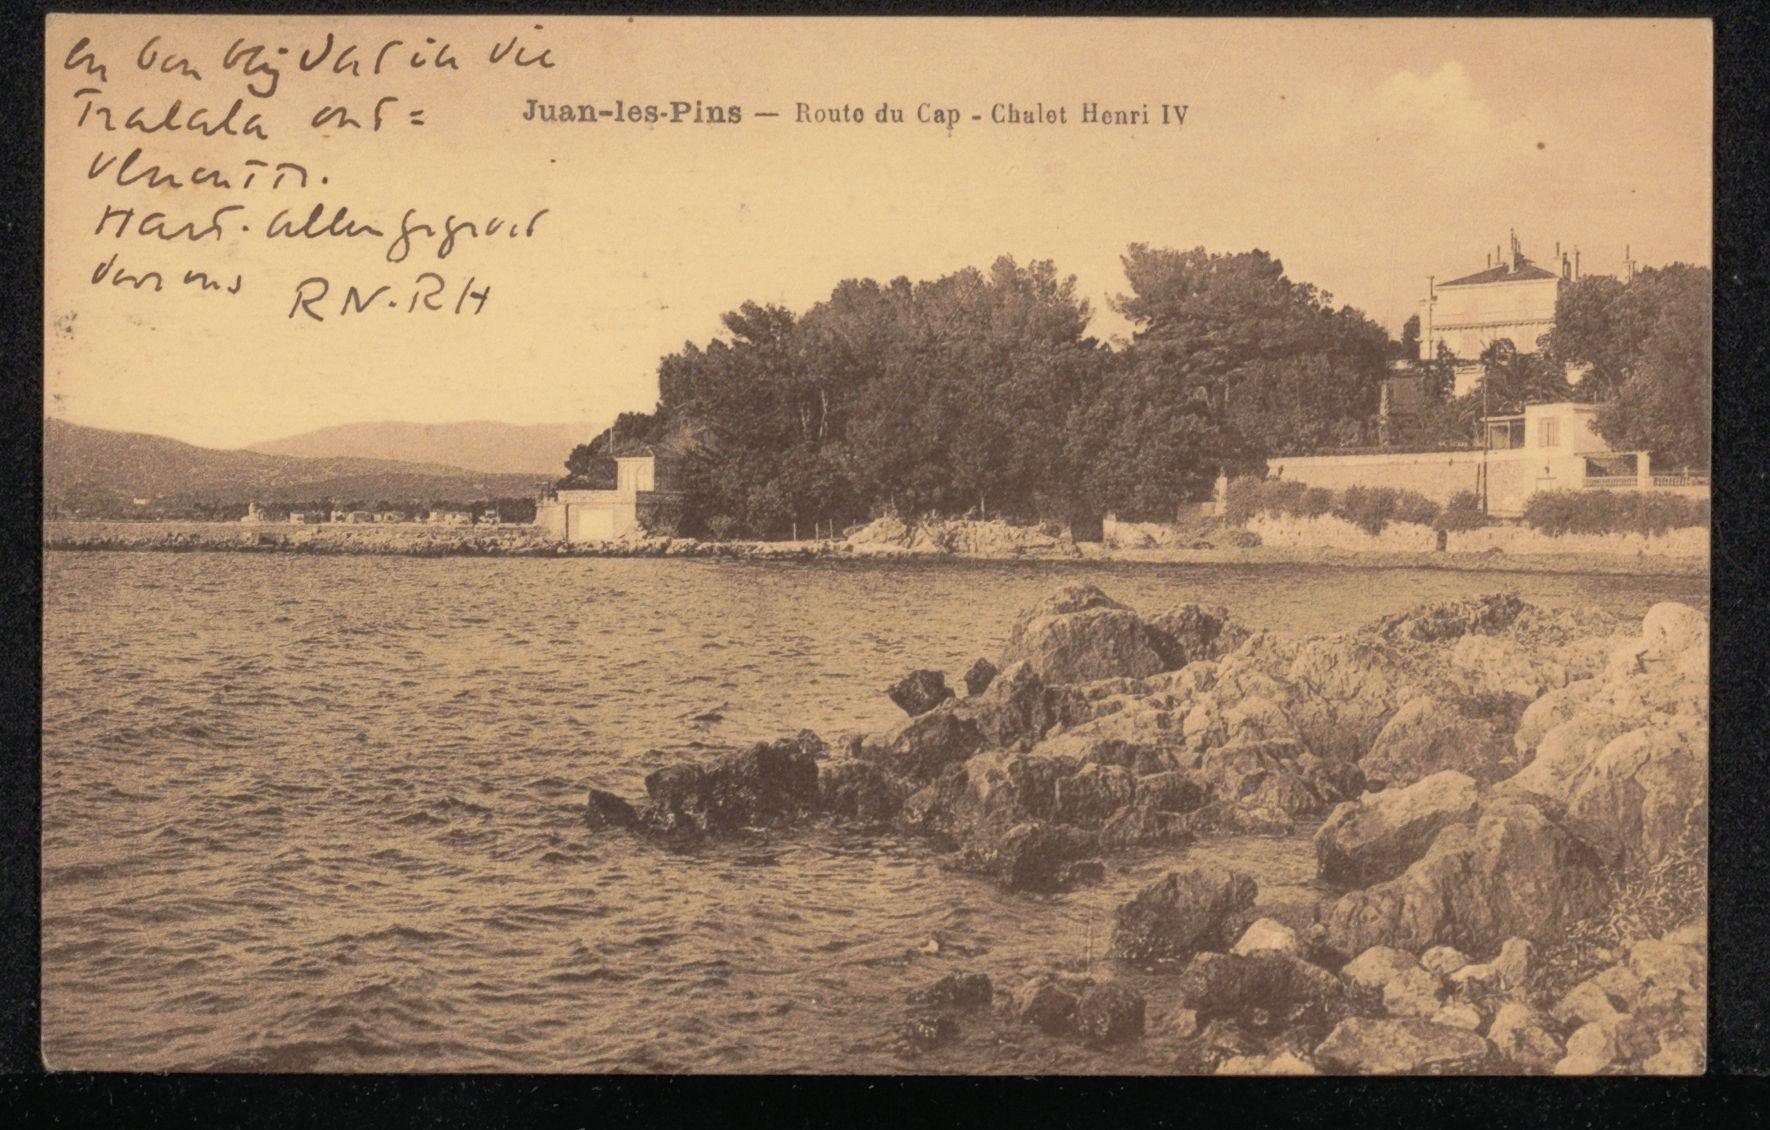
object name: ansichtkaart, prentbriefkaart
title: Prentbriefkaart aan Willem Bogtman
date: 1928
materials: cardboard, ink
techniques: photograph, pen, writing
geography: juan-les-pins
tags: haarlem, willem bogtman